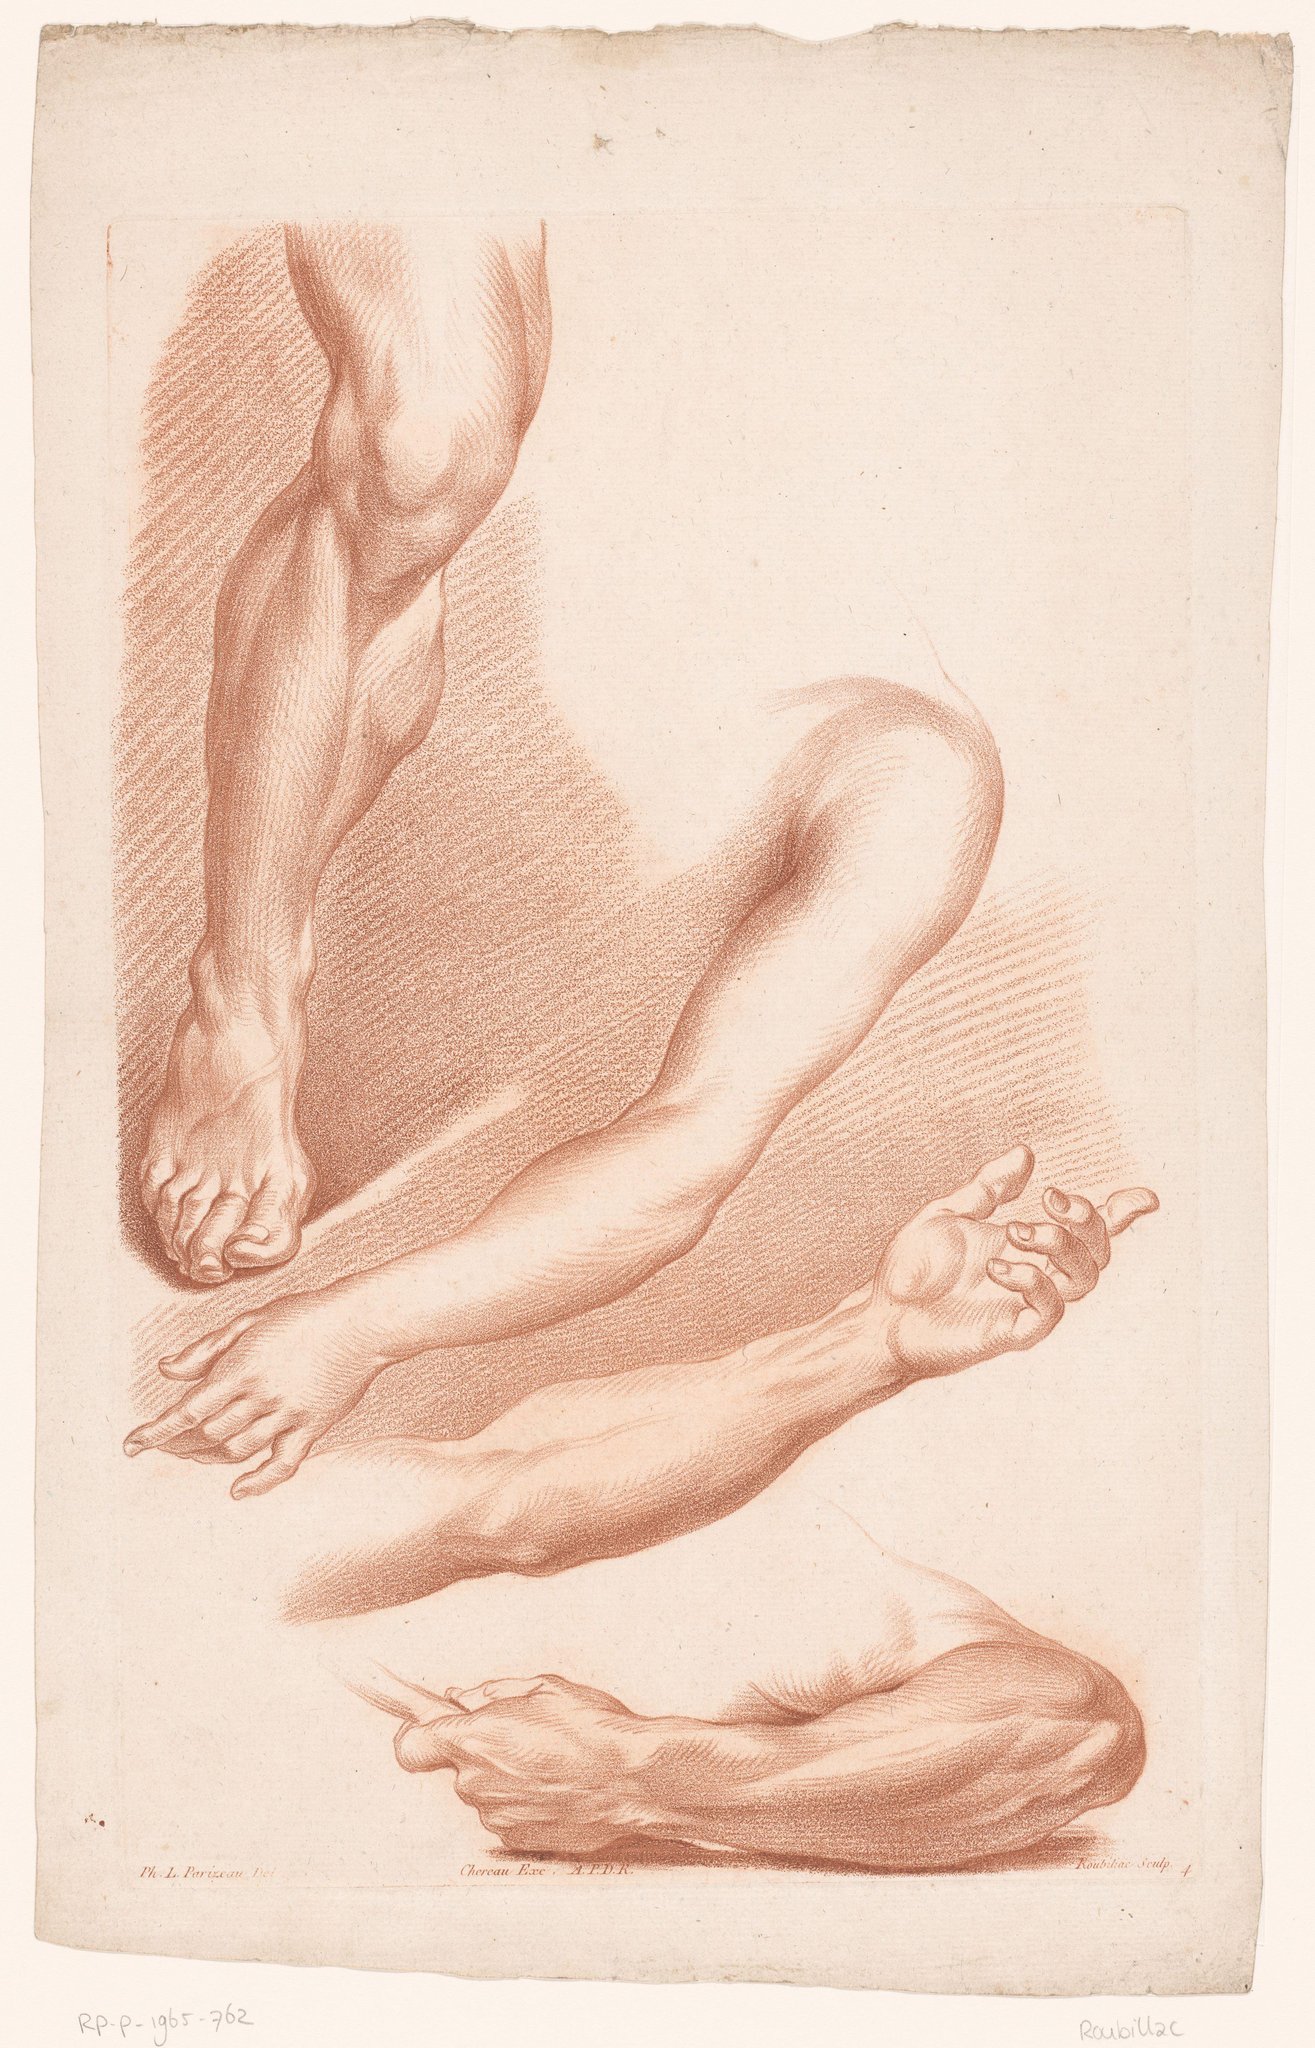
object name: print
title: Principes van het tekenen naar de natuur, deel zeven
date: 1780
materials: paper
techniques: printmaking, etching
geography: france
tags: drawing, sketch, arms, legs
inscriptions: collector's mark: Lugt 2228